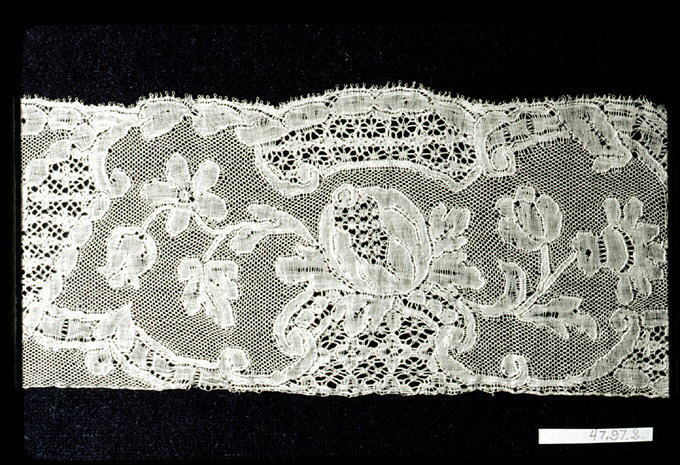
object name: strip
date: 1734-1766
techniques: lace